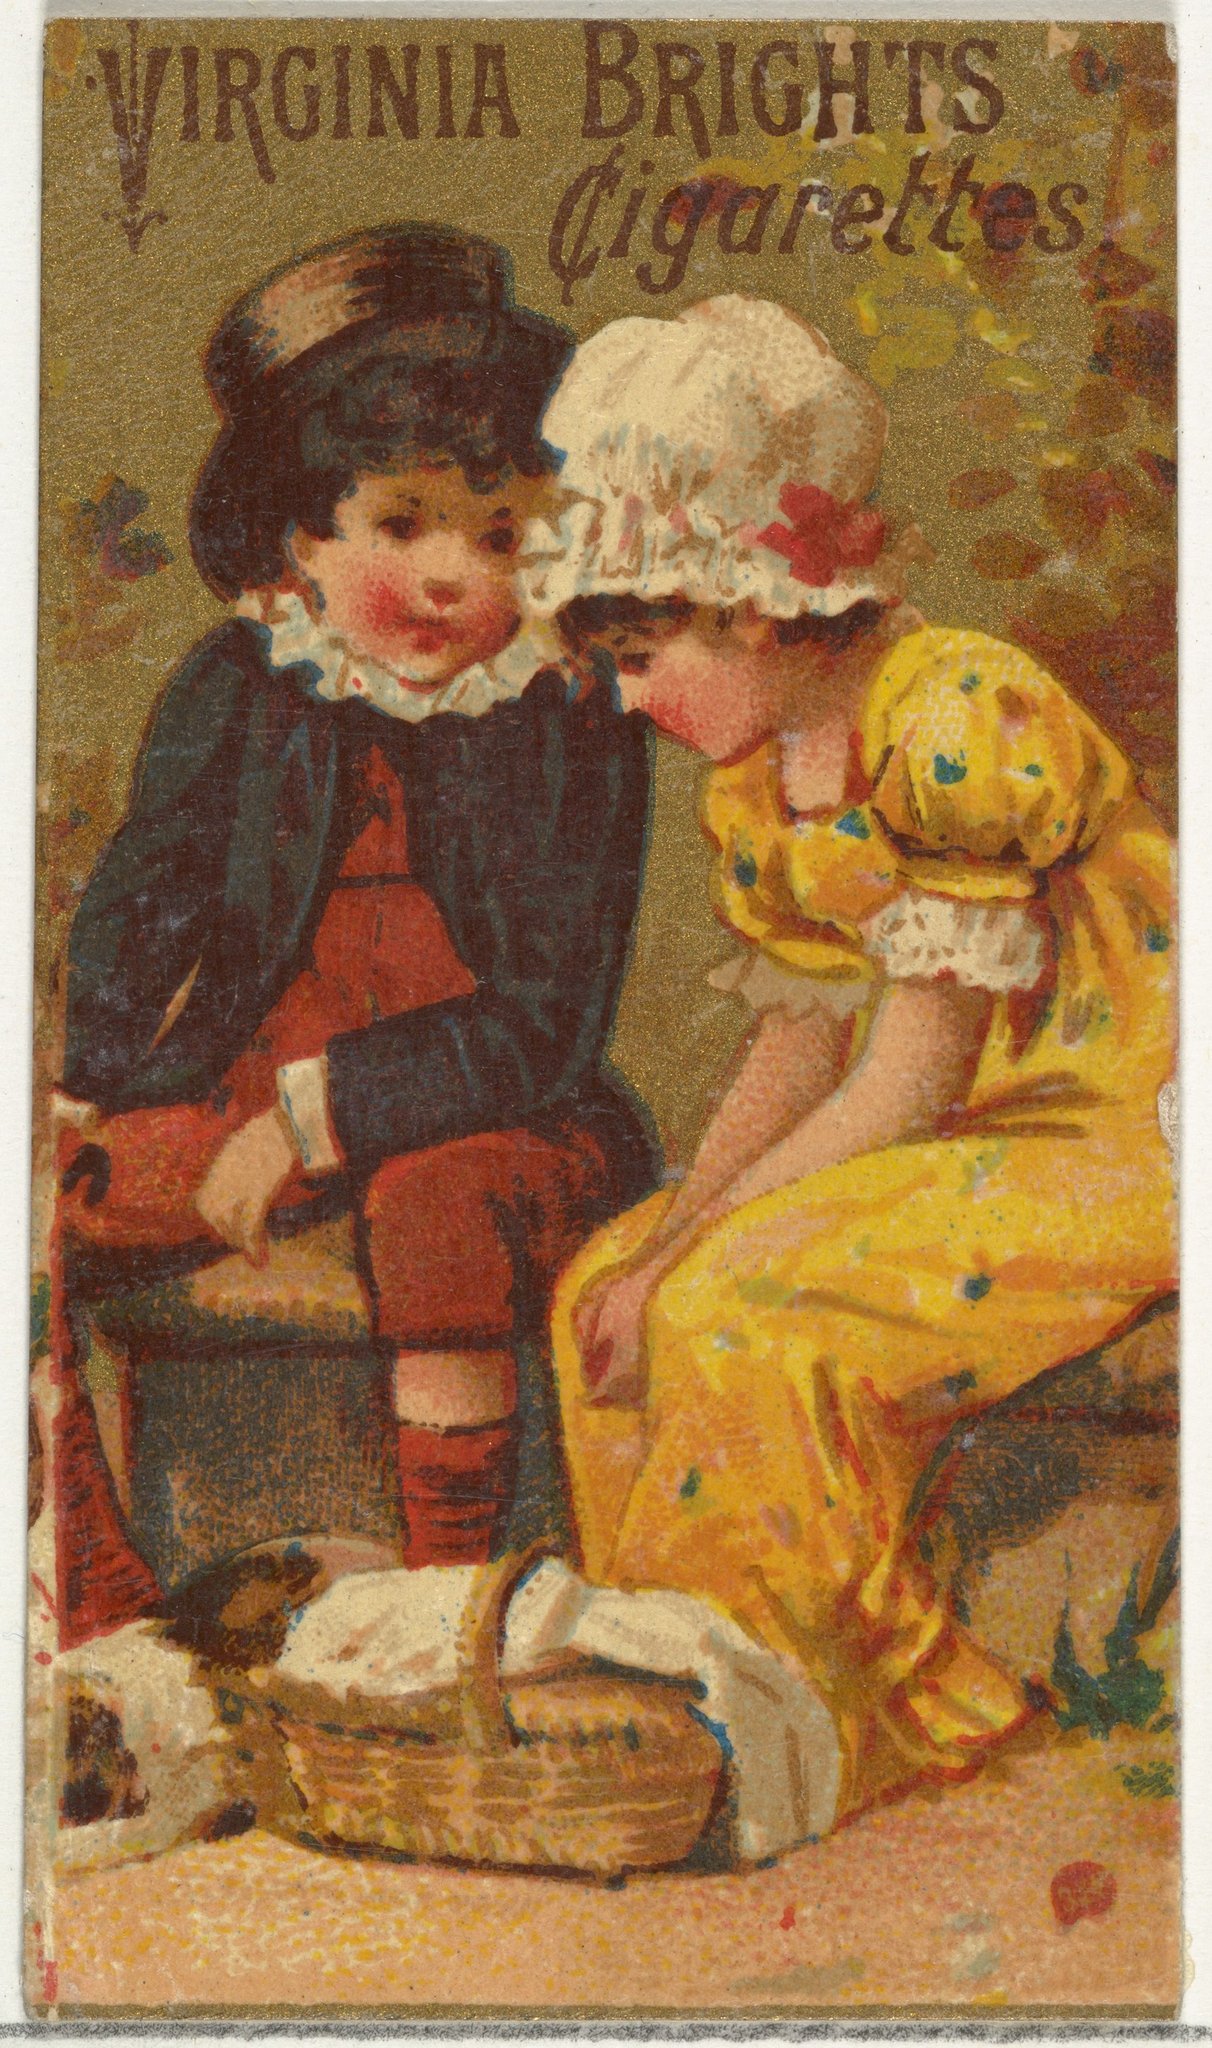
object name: print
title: From the Girls and Children series (N64) promoting Virginia Brights Cigarettes for Allen & Ginter brand tobacco products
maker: allen & ginter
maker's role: publisher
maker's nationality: american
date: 1886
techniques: color lithograph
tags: girls,profiles